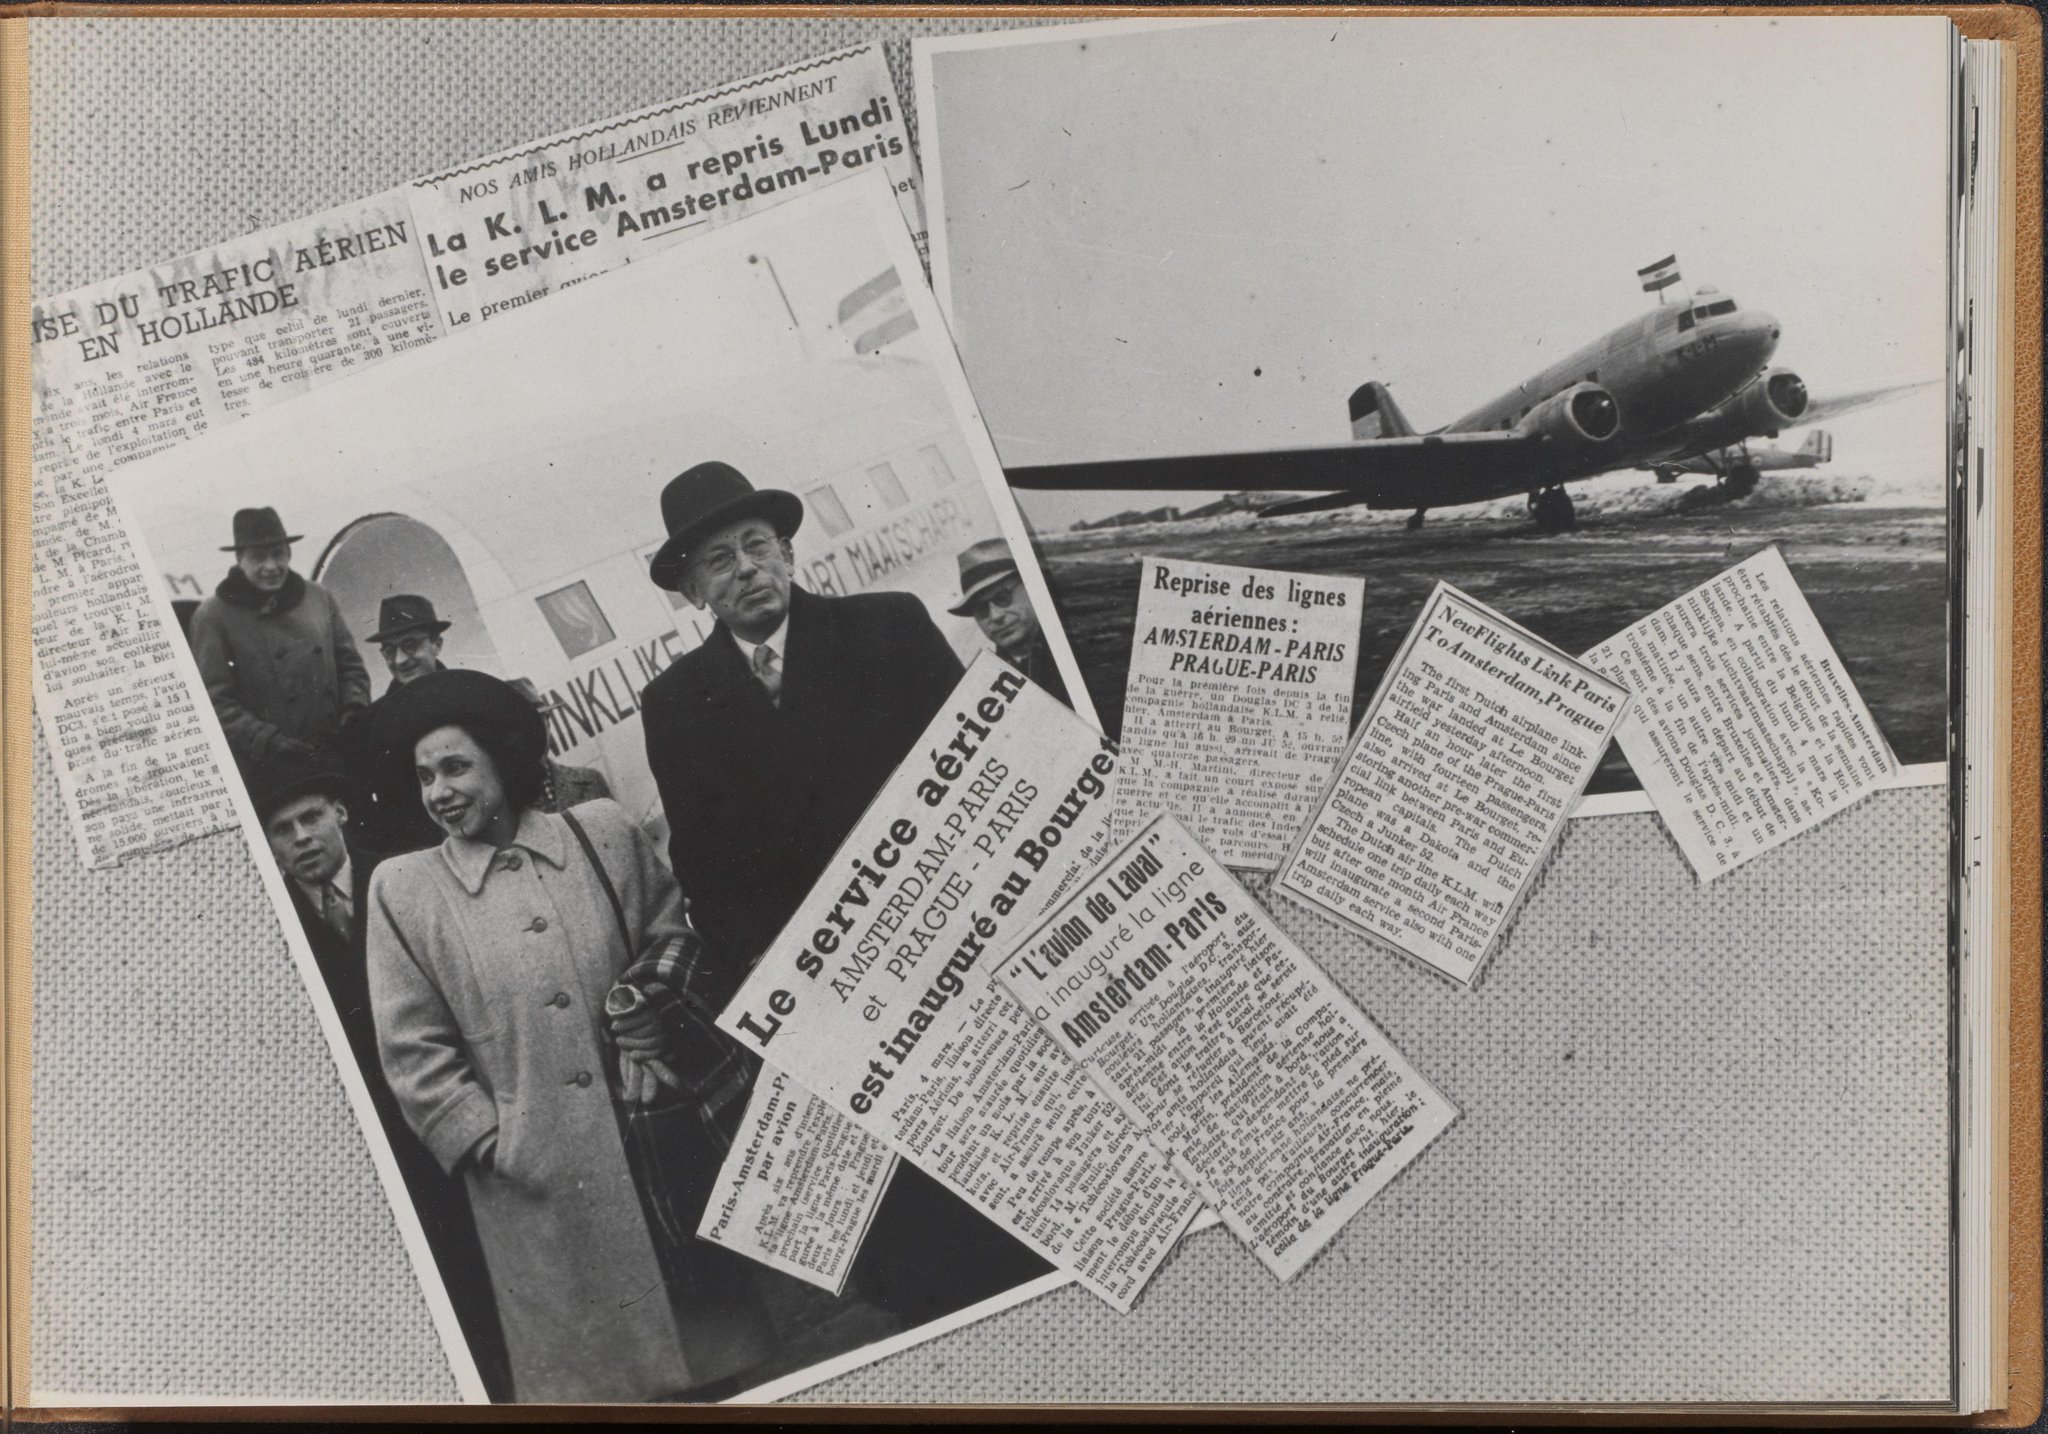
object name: album leaf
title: Herstel KLM-luchtverbinding Amsterdam-Parijs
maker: Anonymous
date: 1949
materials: cardboard, paper, photographic support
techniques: gelatin silver print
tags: leiden, aircraft, aeroplane, airborne traffic, aviation, travelling; tourism, newspaper, news-sheet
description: Albumblad met een compositiefoto van krantenberichten uit 1946 over het herstel van de KLM-luchtverbinding Amsterdam-Parijs, van een KLM-vliegtuig met wapperende vlag en van KLM-directeur Hans Martin. Onderdeel van Herdenkingsalbum van de Indië-lijn van de KLM, deel II.